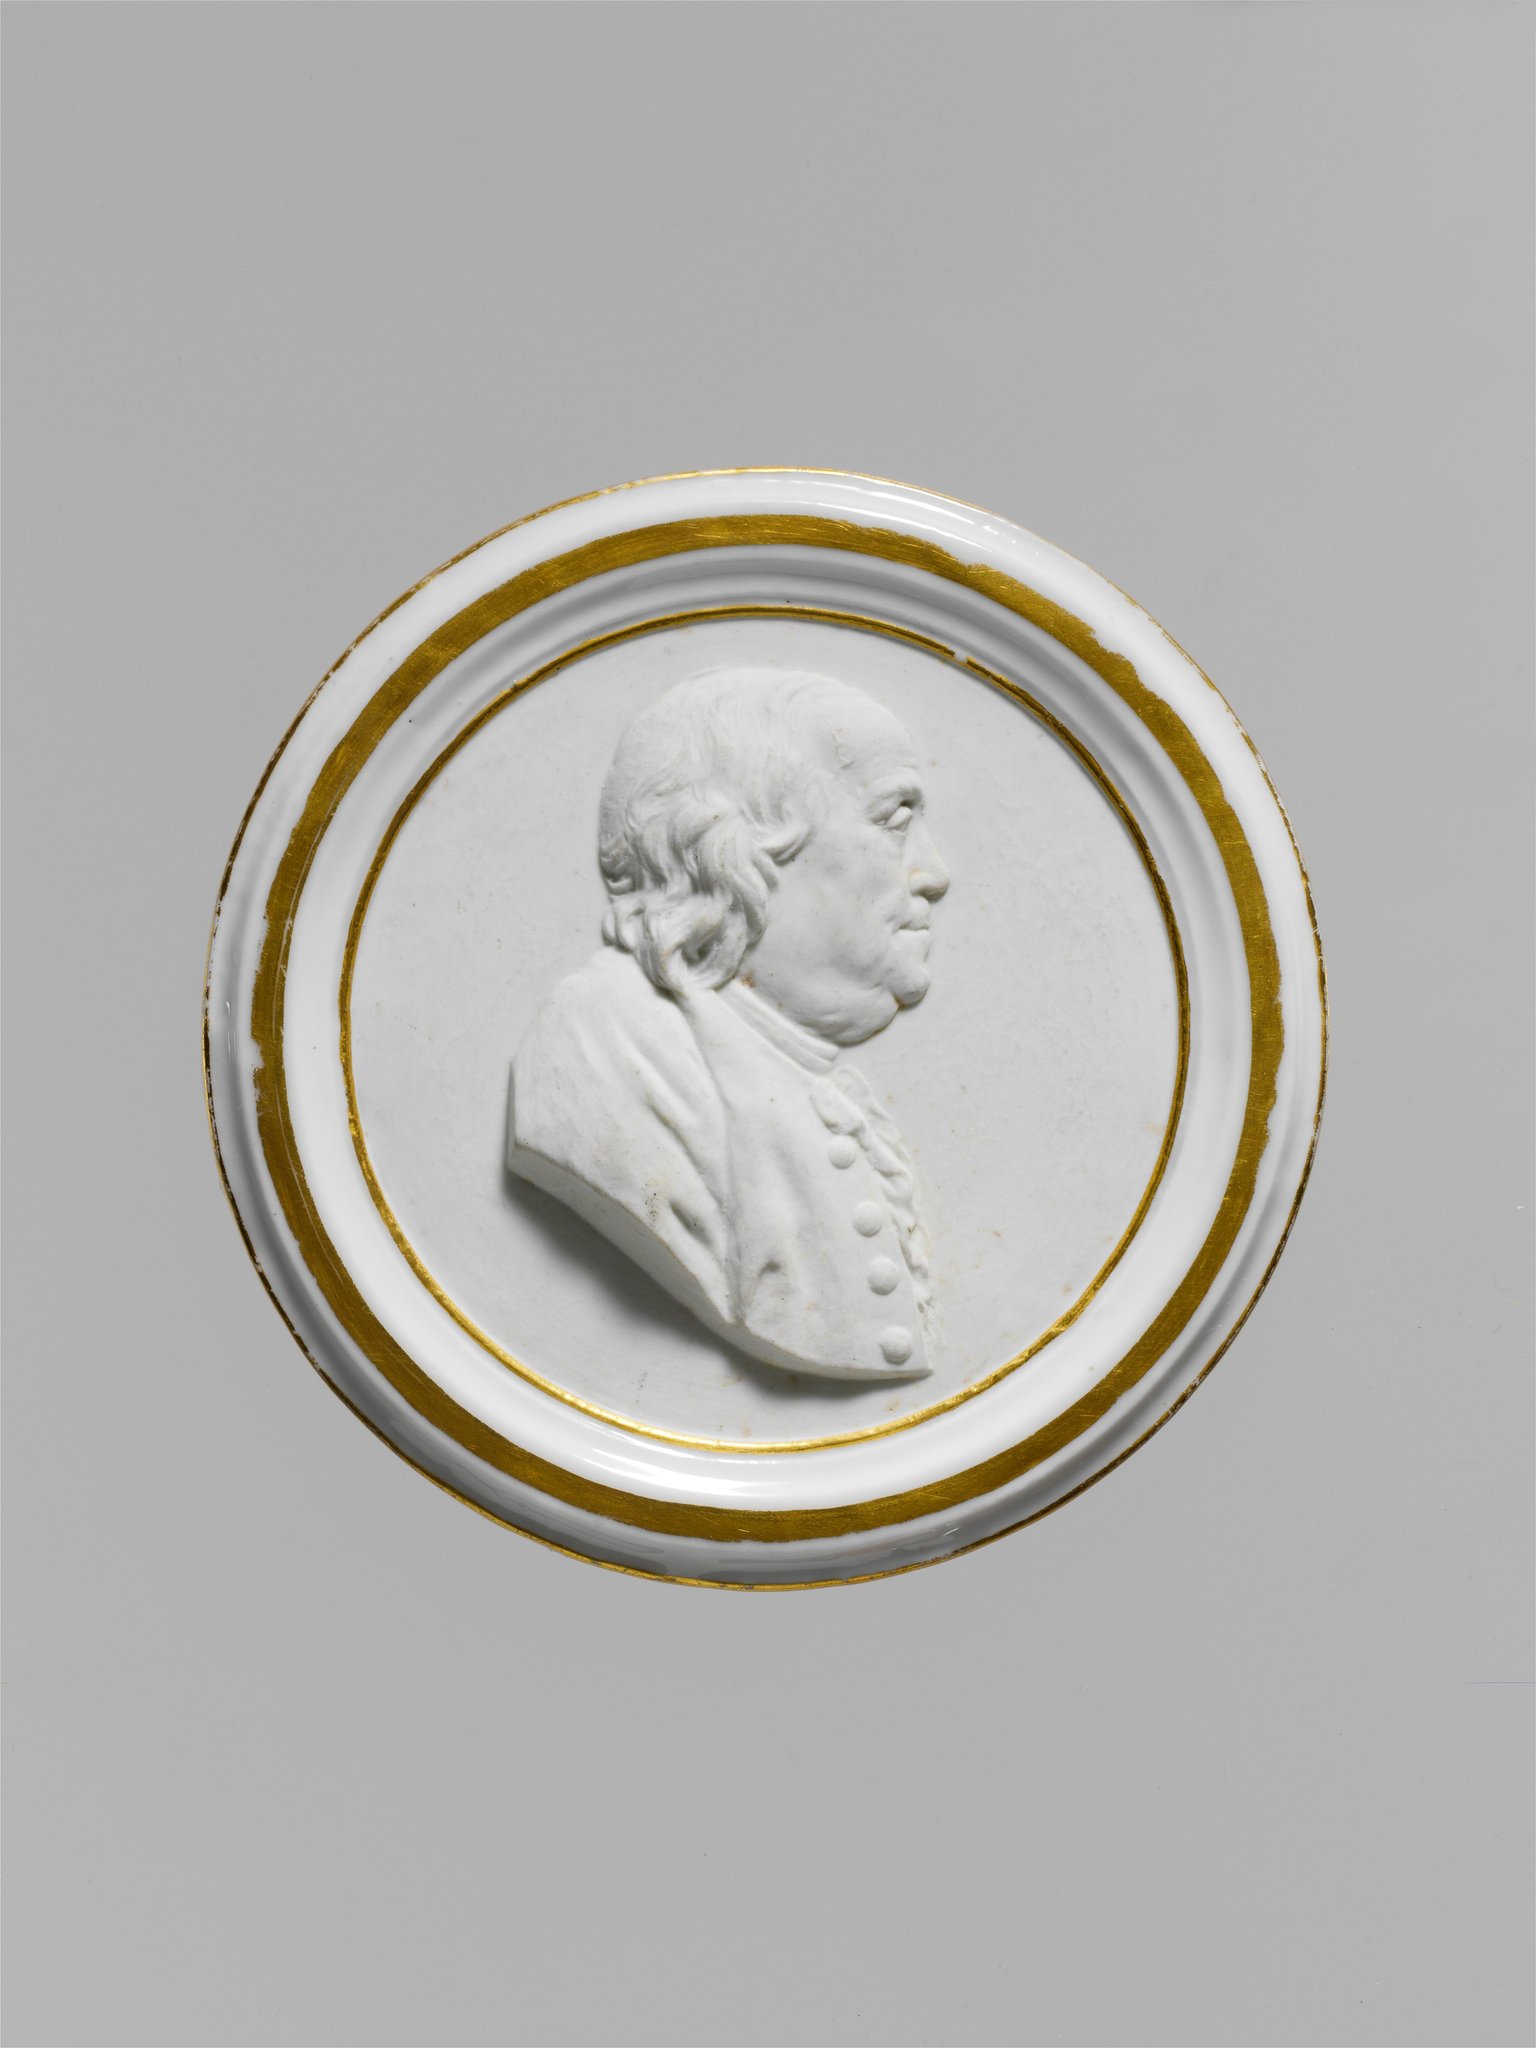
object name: plaque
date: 1776-1800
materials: porcelain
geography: france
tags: men,profiles